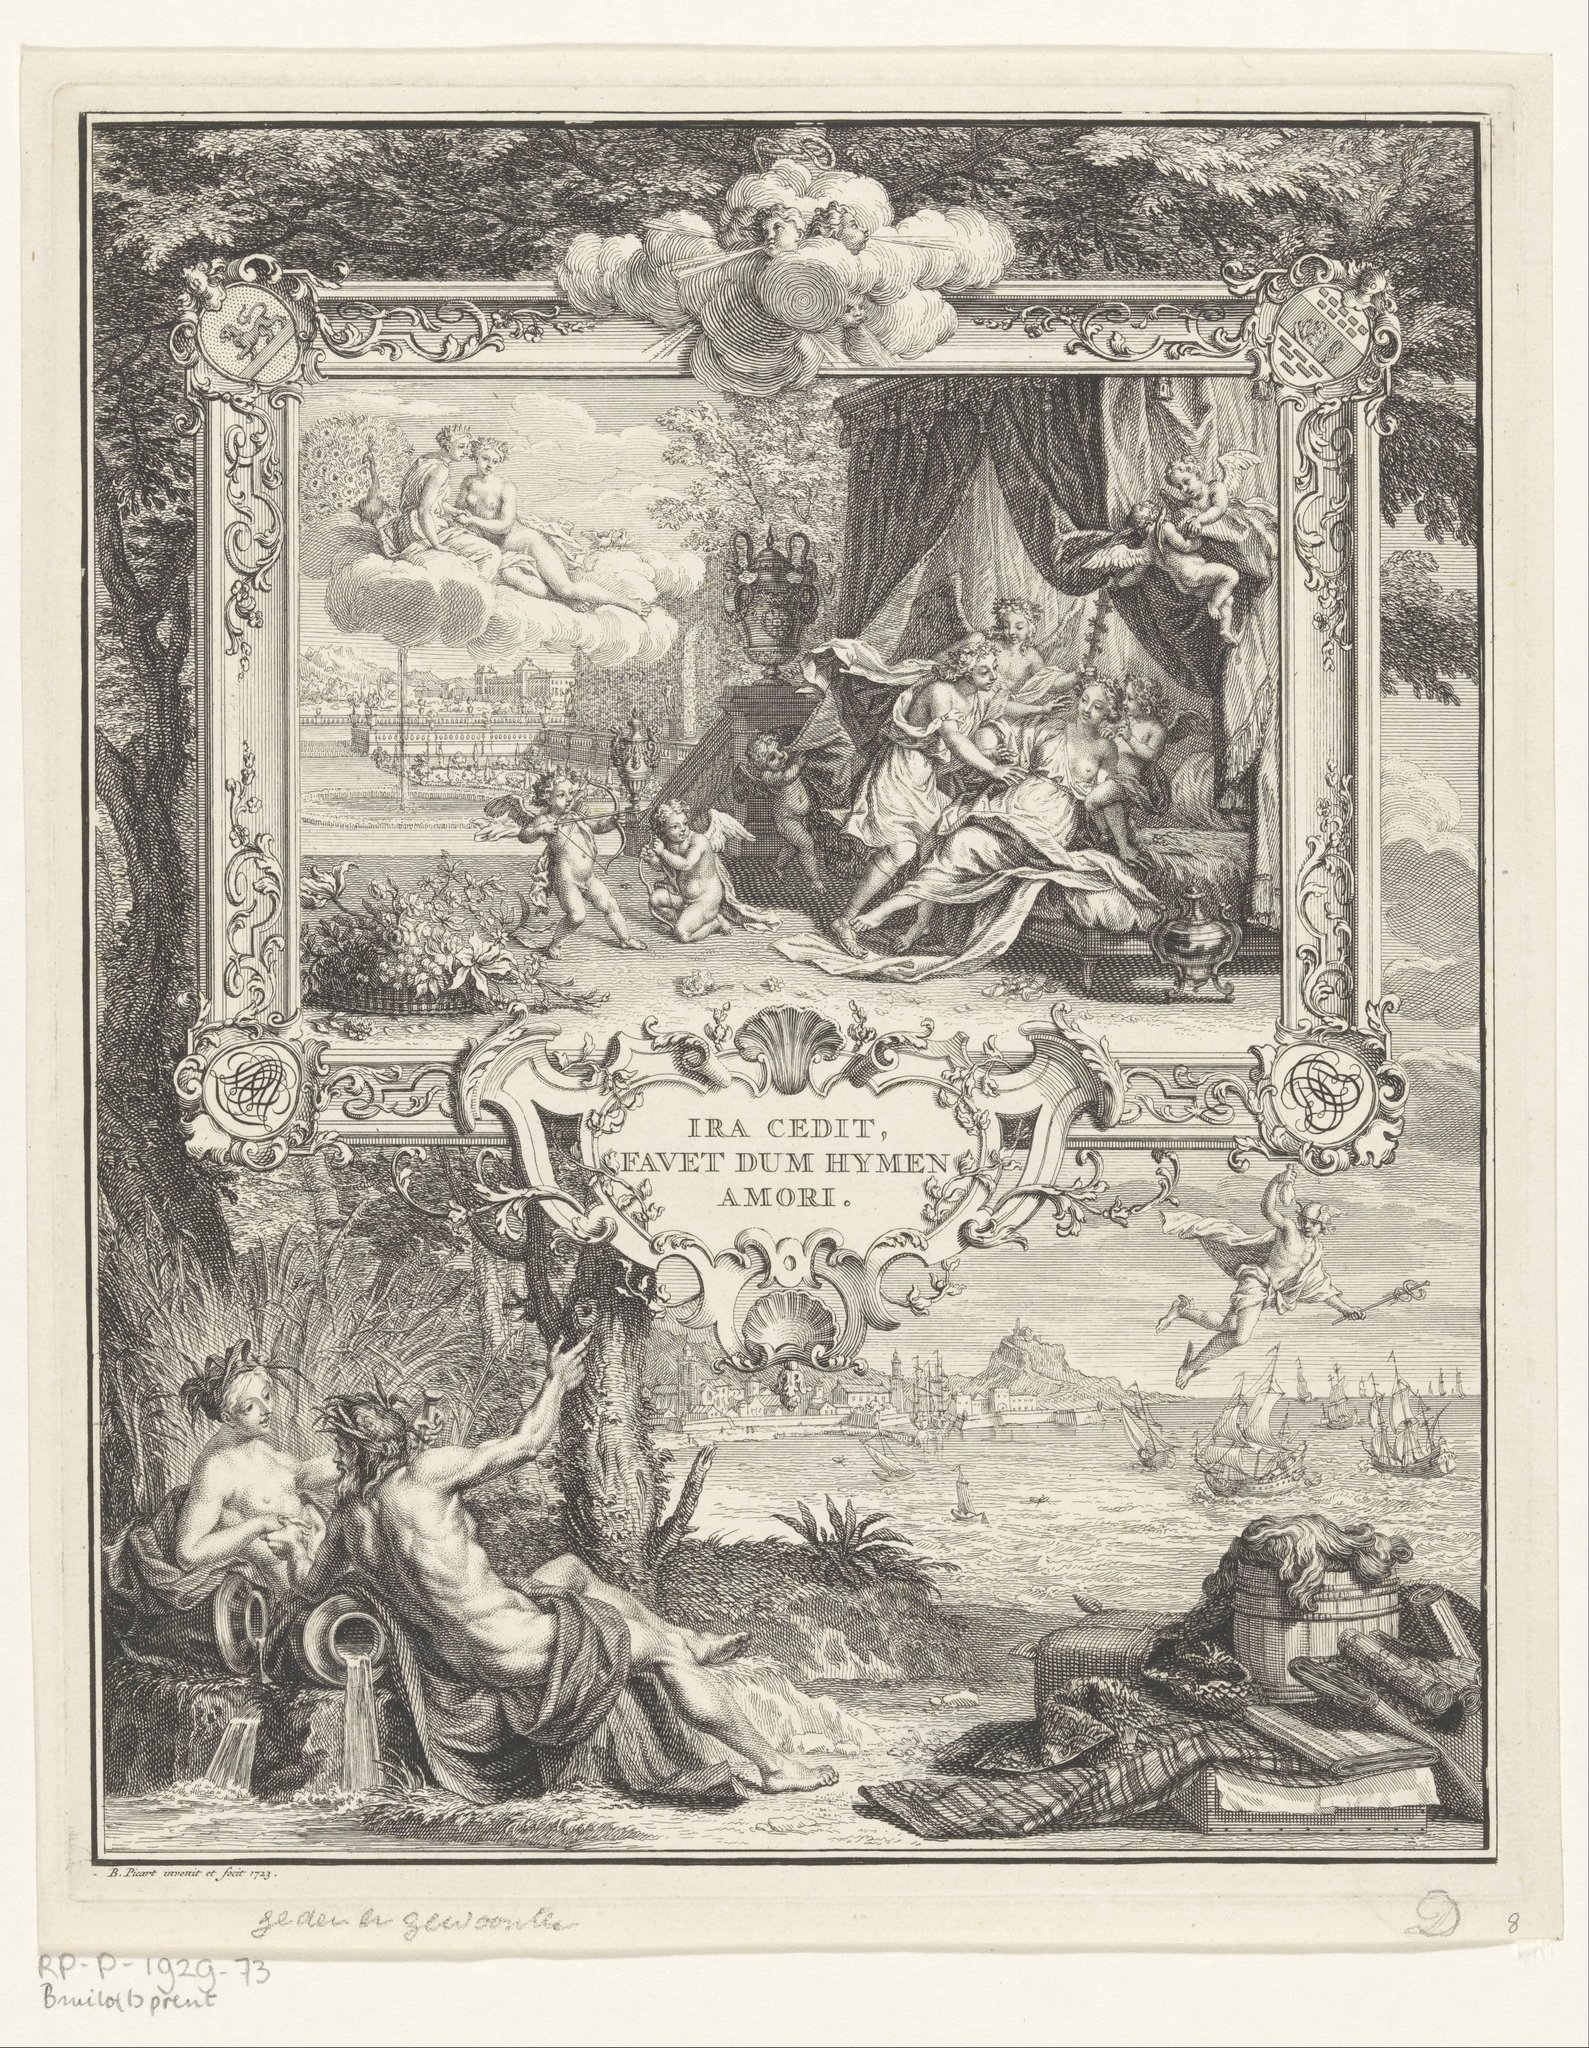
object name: print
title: Allegorische voorstelling ter gelegenheid van het huwelijk van David Leeuw van Lennep en Hester Barnaart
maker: bernard picart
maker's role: draughtsman, print maker, publisher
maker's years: 1673-1733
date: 1723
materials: paper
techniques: engraving, etching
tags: (story of) hymen(aeus), (story of) juno (hera), marriage, married couple, 'matrimonium', (story of) venus (aphrodite)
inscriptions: collector's mark: Lugt 240, collector's mark: Lugt 2166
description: Allegorische voorstelling ter gelegenheid van het huwelijk van David Leeuw van Lennep en Hester Barnaart te Haarlem op 25 mei 1723. De echtgenoot wordt door Hymen naar het huwelijksbed gebracht, waar zij hem licht afweert. Juno, als beschermster van de vrouwen, en Venus, als godin van de liefde, zitten boven op een wolk. De voorstelling is gevat in een ornamentele lijst. Onder de stroomgoden van het IJ en het Spaarne. Handelswaar, schepen en de handelsgod Mercurius geven de bezigheden van het echtpaar als kooplieden weer. Onder de voorstelling het devies: Ira cedit, favet dum hymen amori.